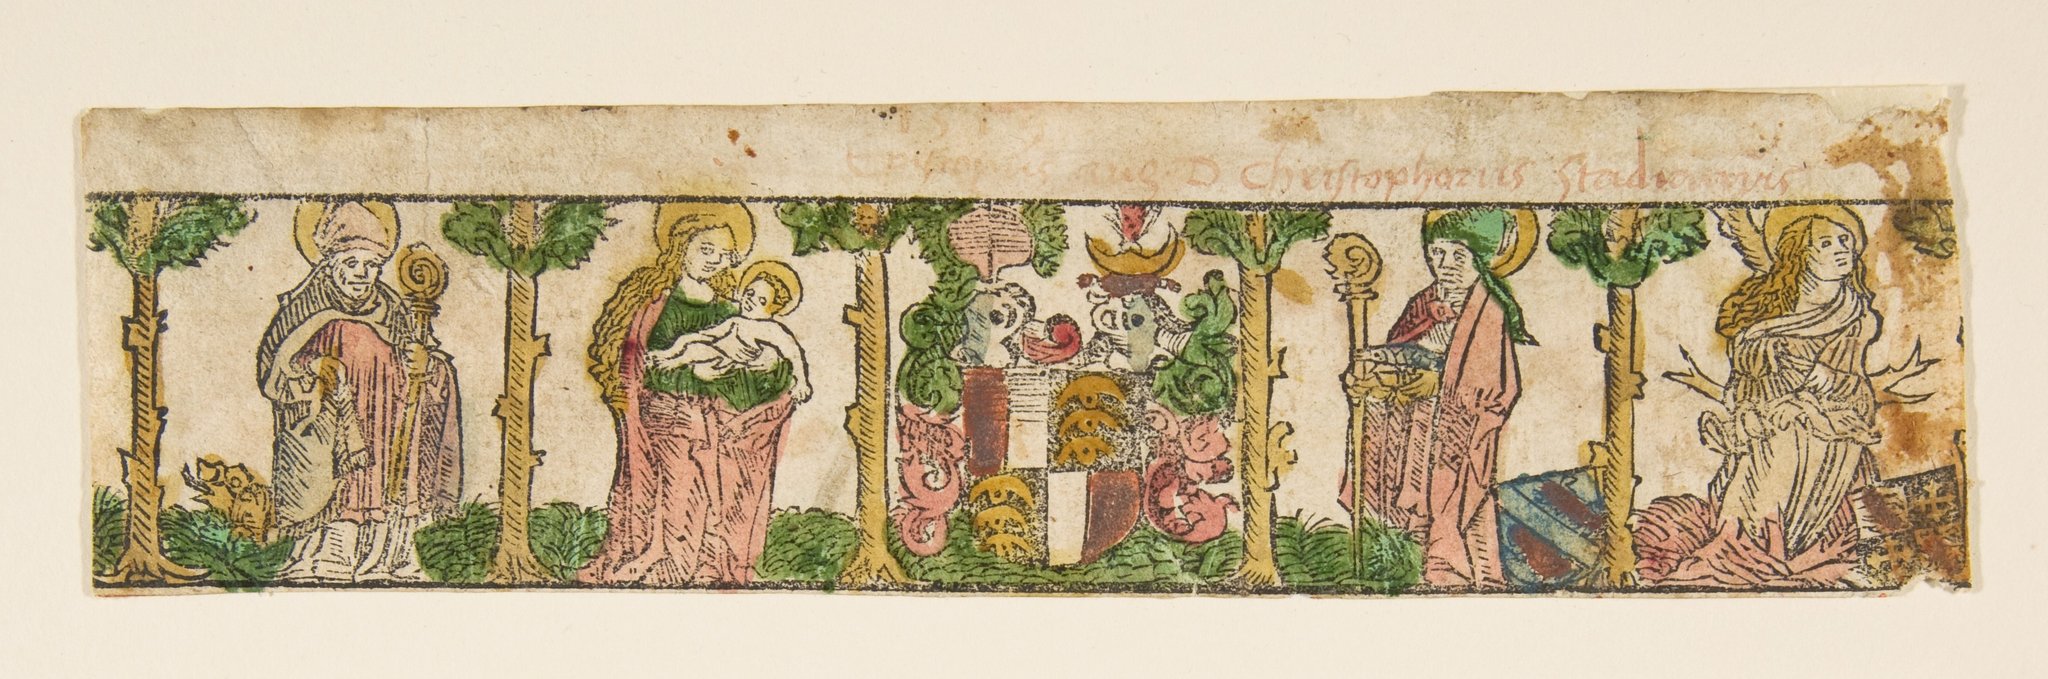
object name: print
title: Ornamental Border of the Augsburg Diocese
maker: anonymous, german, 15th century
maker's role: artist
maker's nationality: german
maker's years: 1400-1500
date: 1401-1500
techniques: hand coloring, woodcut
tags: madonna and child,saints